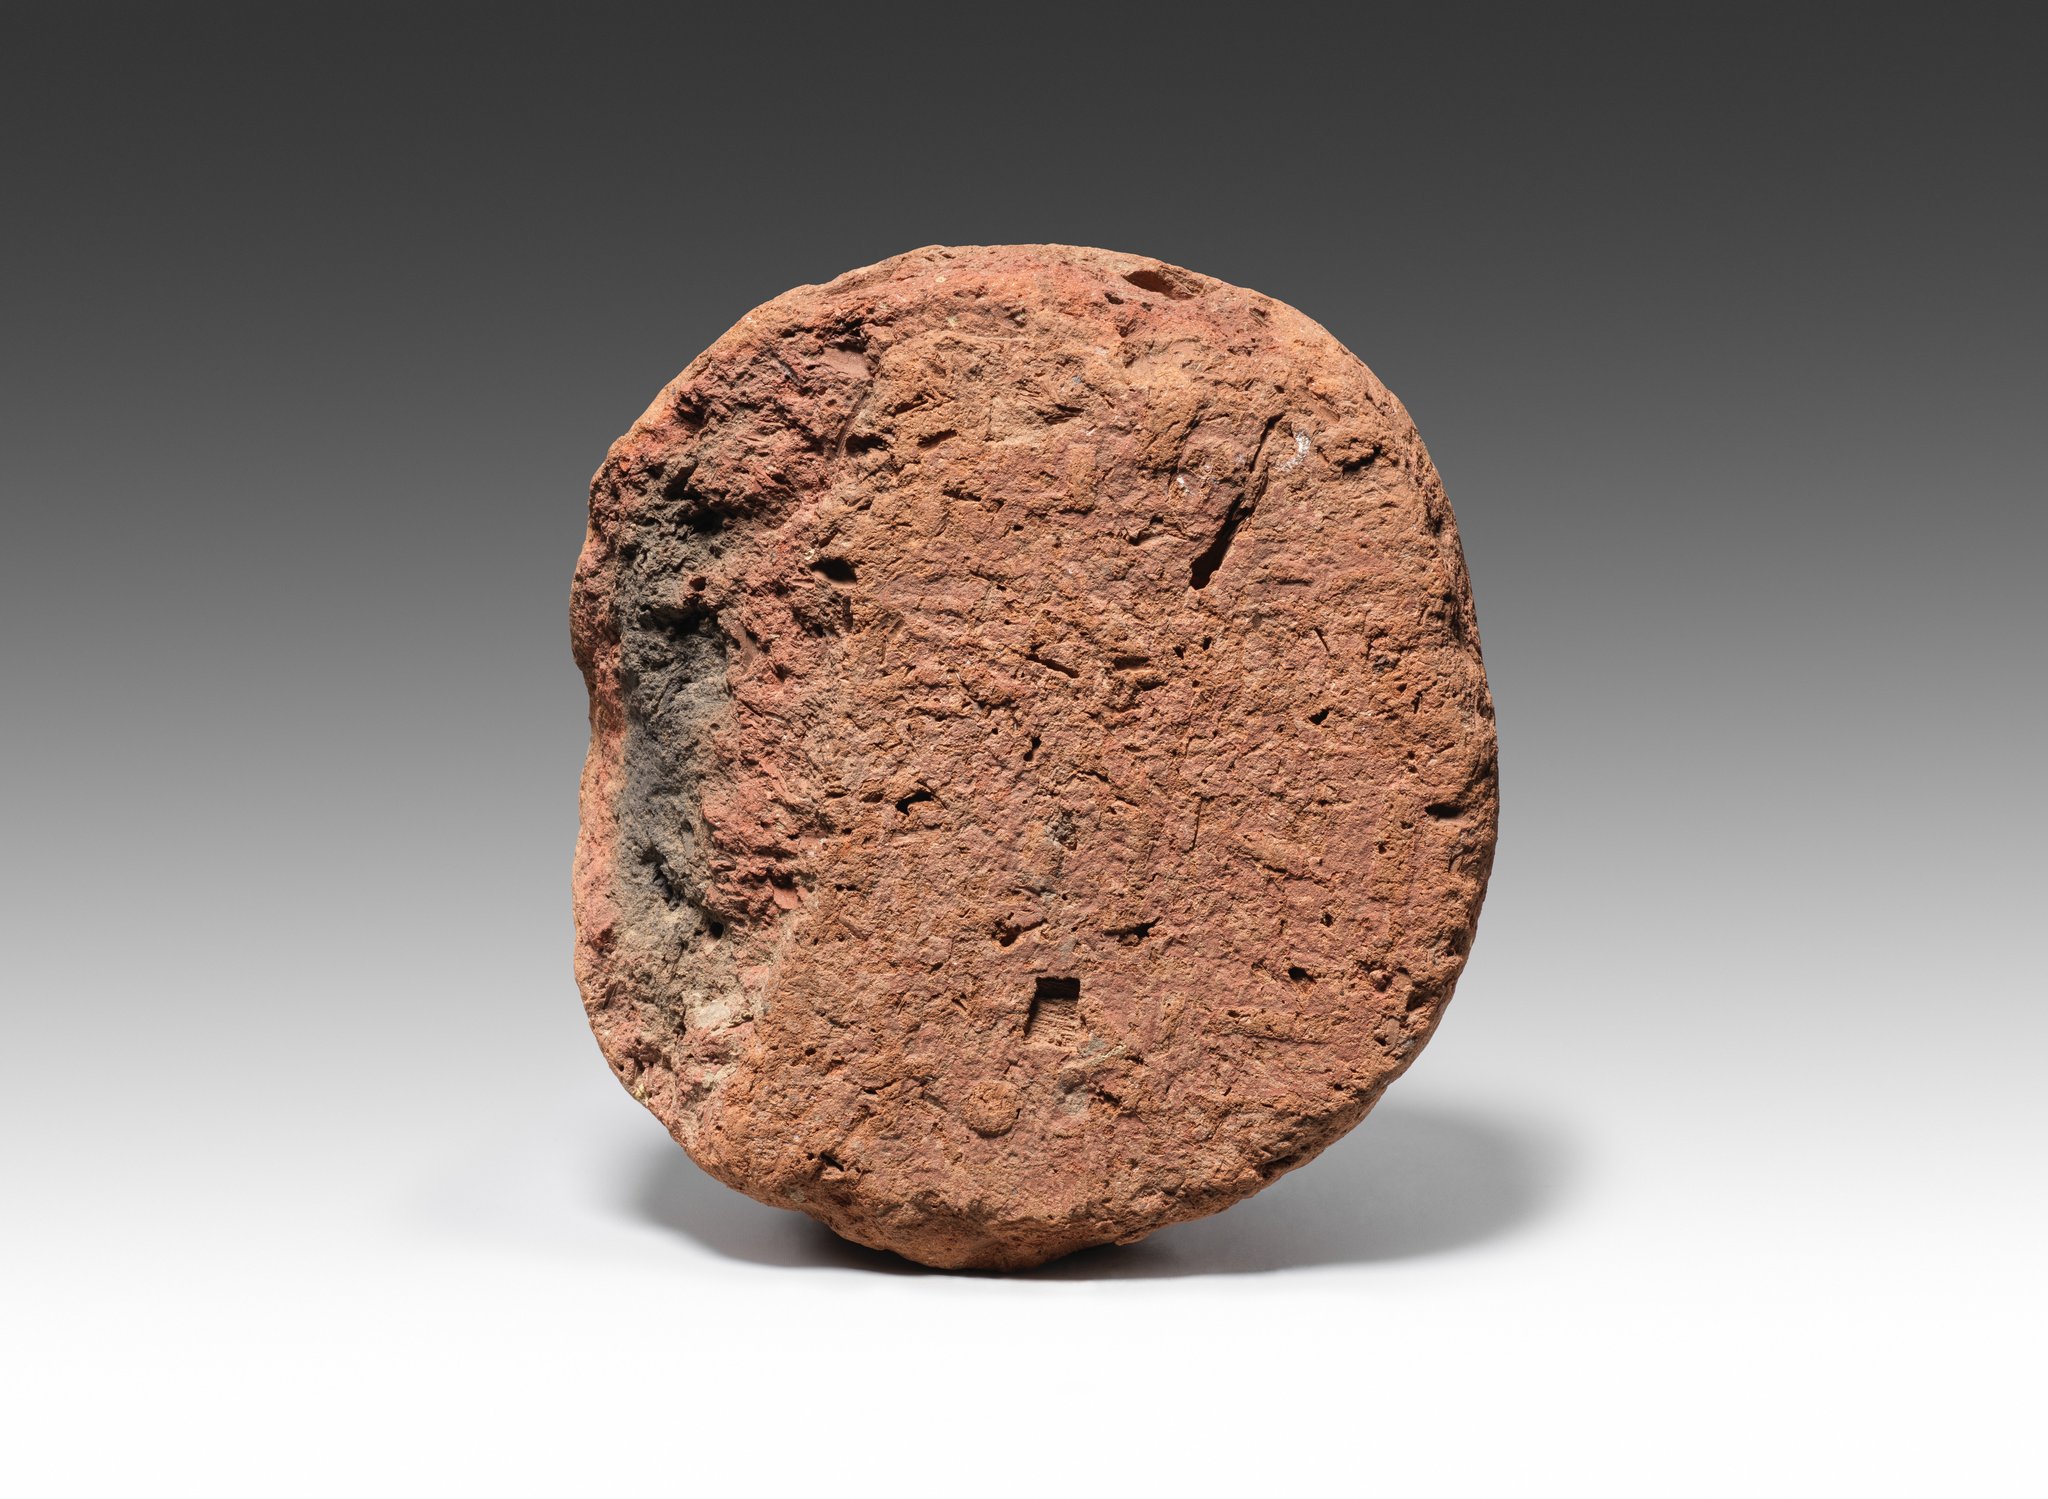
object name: cone, iby, round, chancellor, divine adoratrice, ankhhor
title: Funerary Cone of Iby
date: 712-525 BCE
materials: pottery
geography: egypt